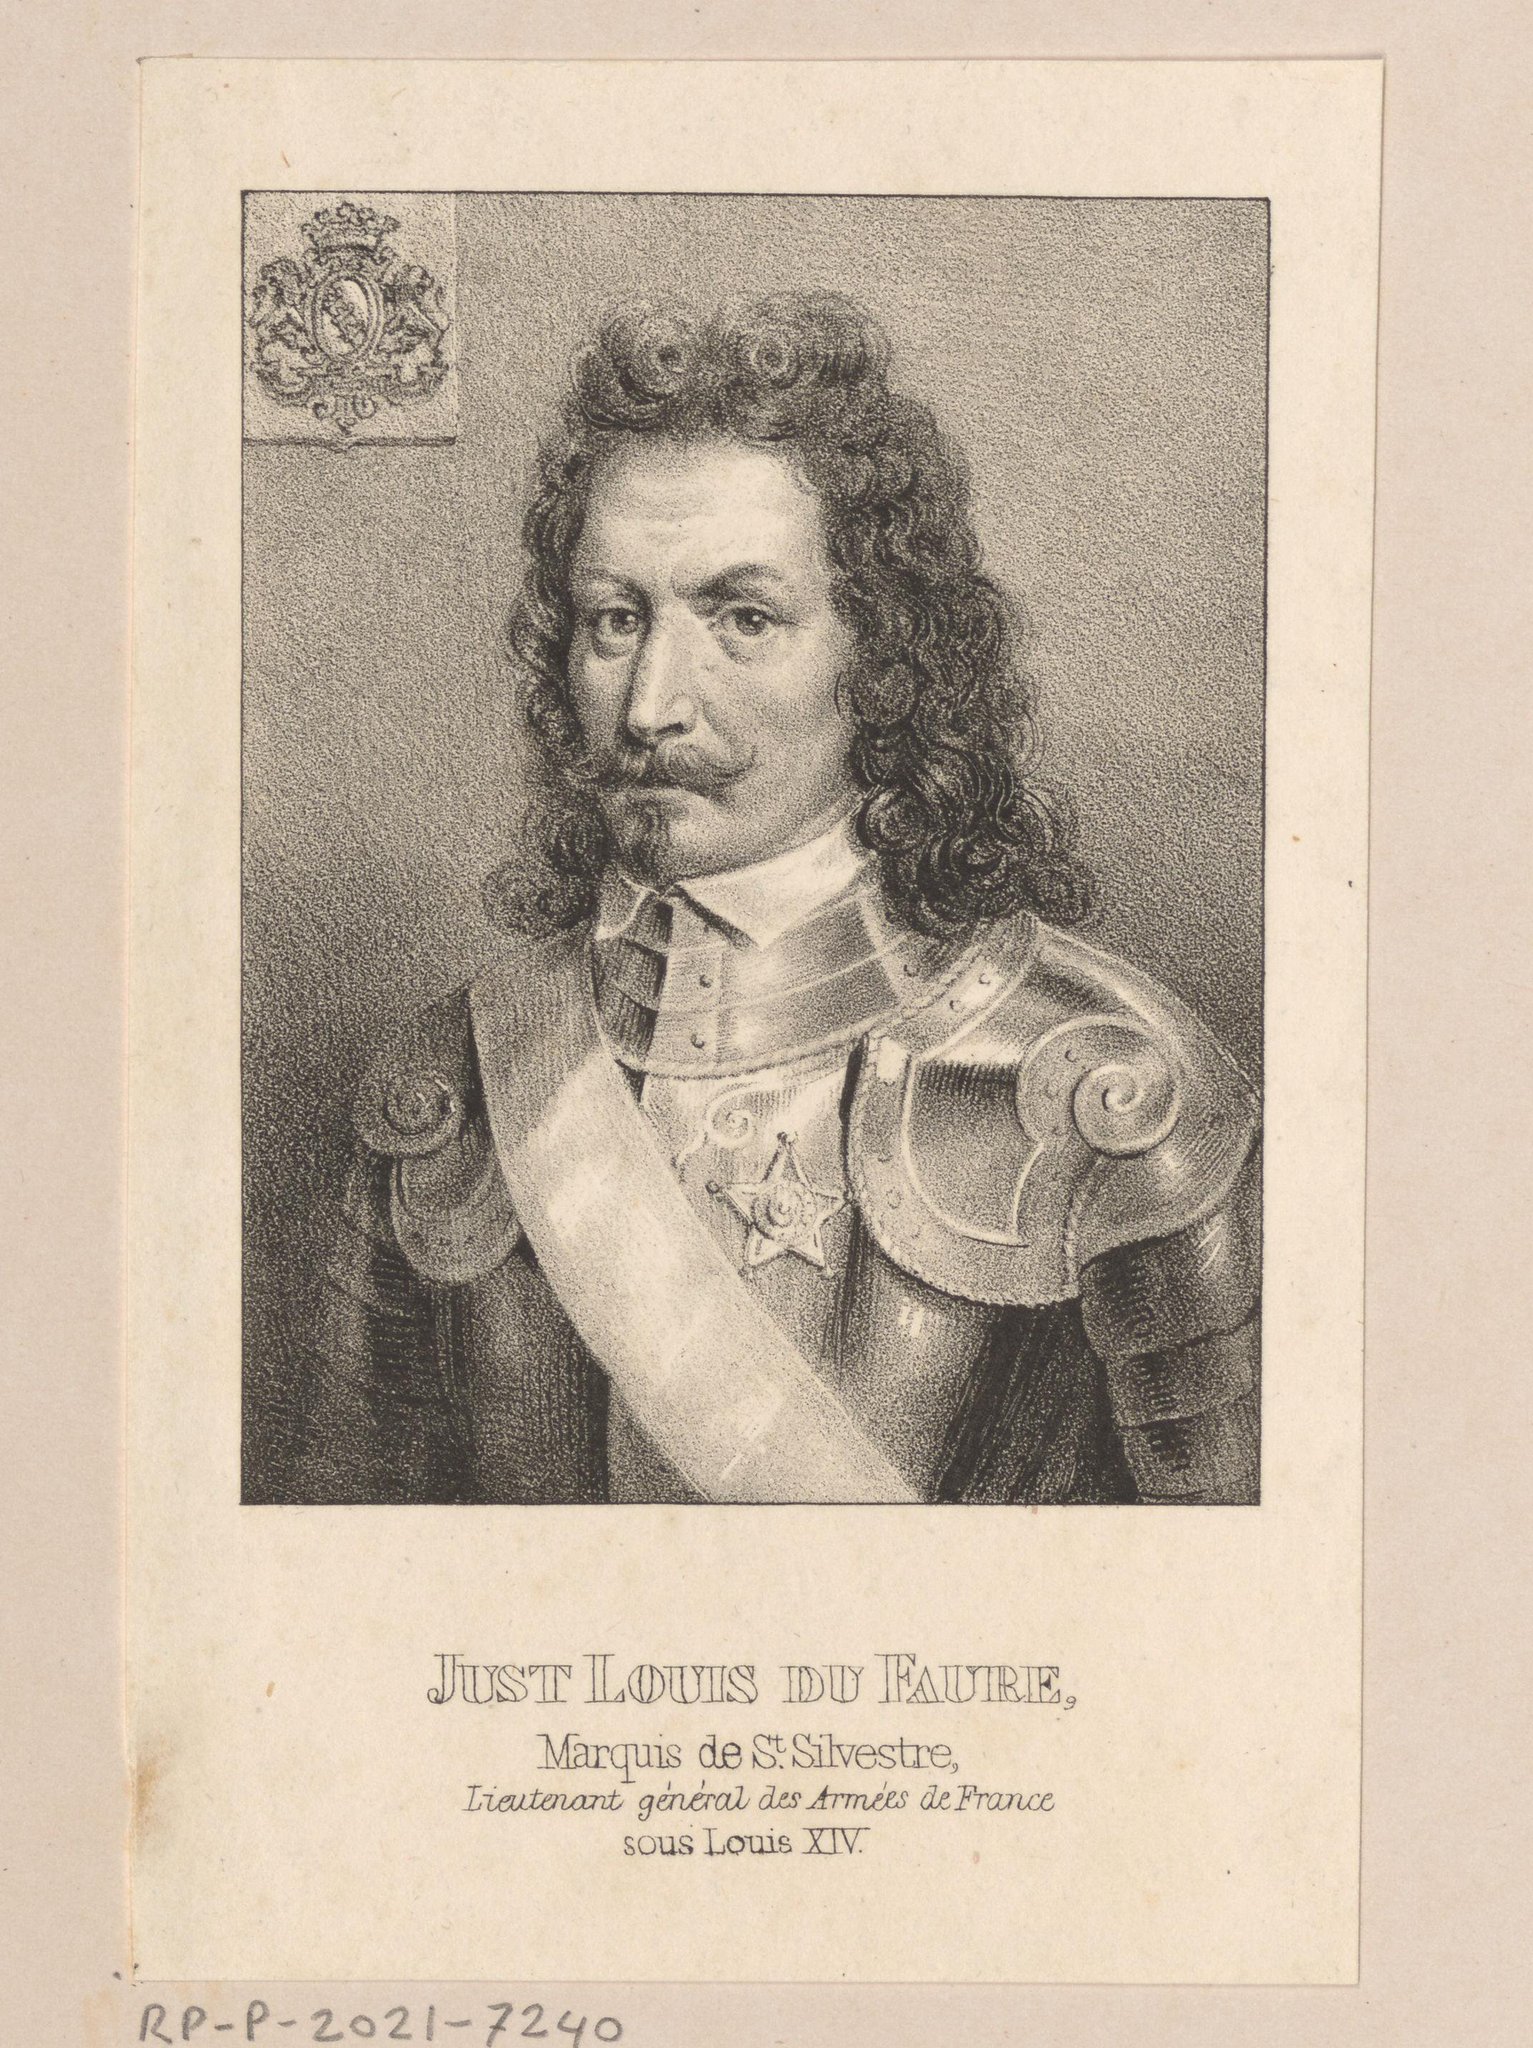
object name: print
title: Portret van Just Louis du Faure, markies van Saint Silvestre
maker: Anonymous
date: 1825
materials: paper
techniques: lithograph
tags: historical persons, armorial bearing, heraldry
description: Prent waarschijnlijk uit: Du Faure de Vercours, M. Memoires historiques sur le Marquis de St-Silvestre (...). Brussel: Baudouin frères, 1825.